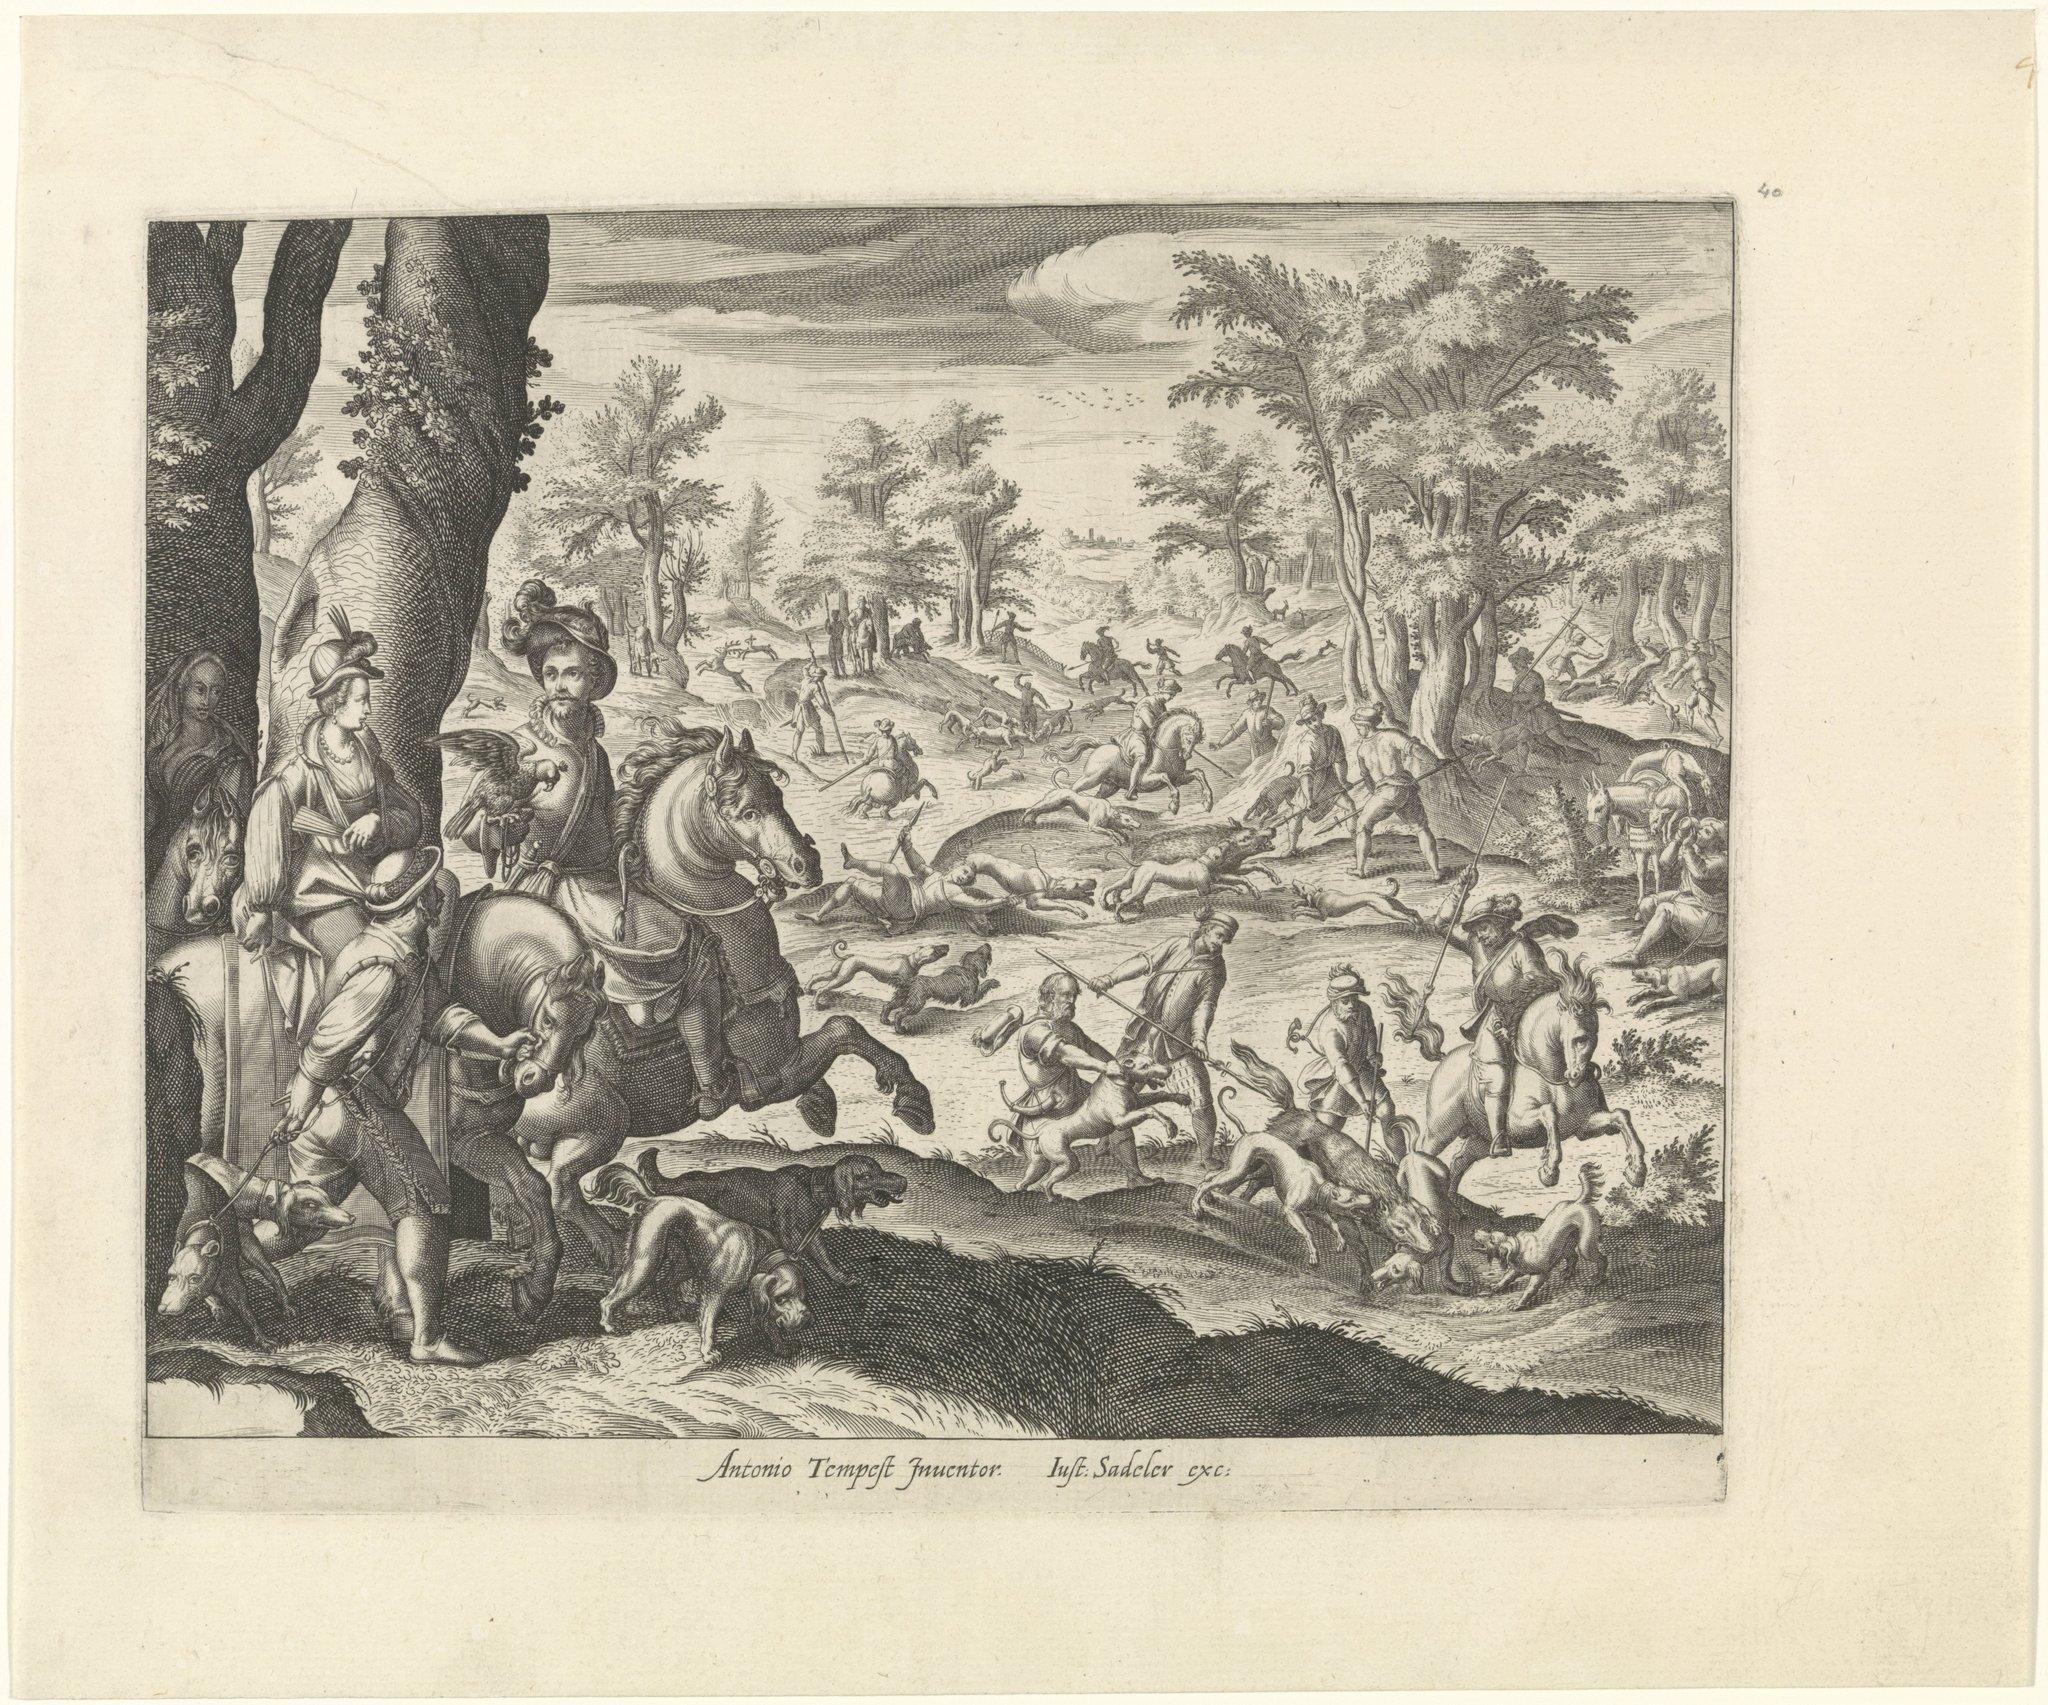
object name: print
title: Landschap met klopjachten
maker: justus sadeler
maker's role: print maker, publisher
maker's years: 1583-1620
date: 1600-1620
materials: paper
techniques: engraving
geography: venice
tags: hunt ~ hoofed animals (+ animals used for hunting, hunting with animals), forest, wood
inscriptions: collector's mark: Lugt 2228, collector's mark: Lugt 2760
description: Een boslandschap met verschillende klopjachten. Op de voorgrond een adellijk gezelschap te paard. De man heeft een jachtvalk op zijn arm. Rechts wordt een wolf door jagers en jachthonden aangevallen. Op de achtergrond de jacht op een everzwijn en herten.